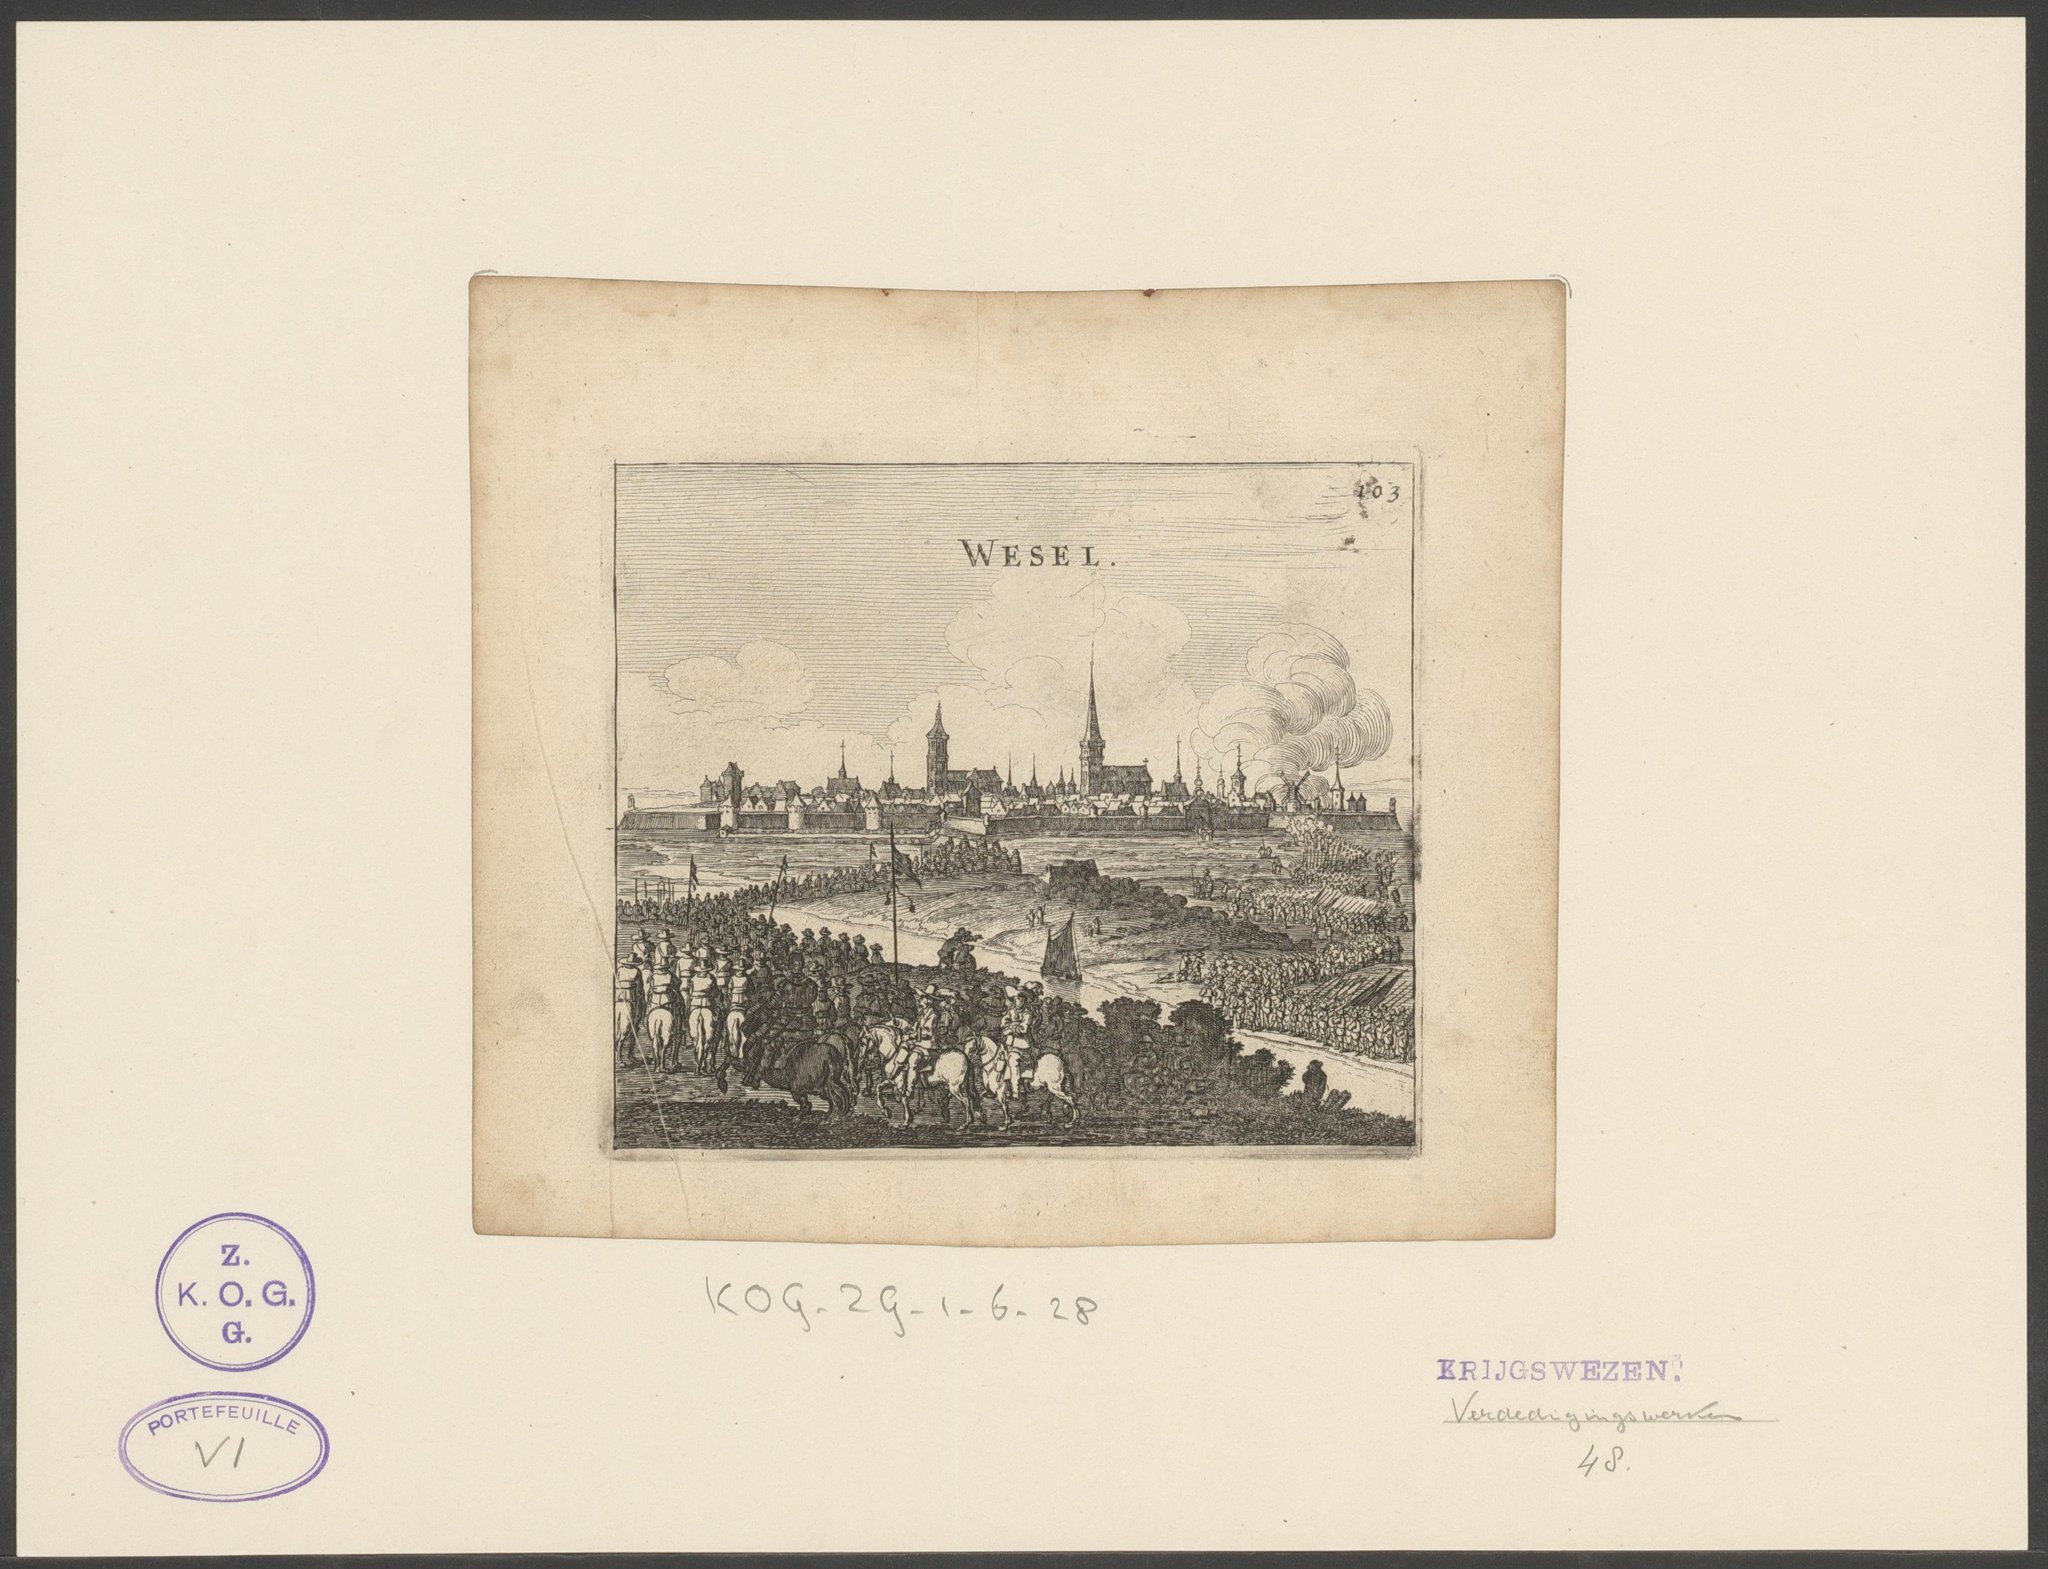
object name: book illustration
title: Wesel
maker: Anonymous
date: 1650-1699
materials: paper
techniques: engraving, etching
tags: siege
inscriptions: collector's mark: Lugt 1641, stamp, stamp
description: Gezicht op het beleg van Wesel in 1614. Rechtsboven genummerd: 218. Onderwerpsrubrieken binnen de Atlas Zeden en Gewoonten: Krijgswezen, Verdedigingswerken.